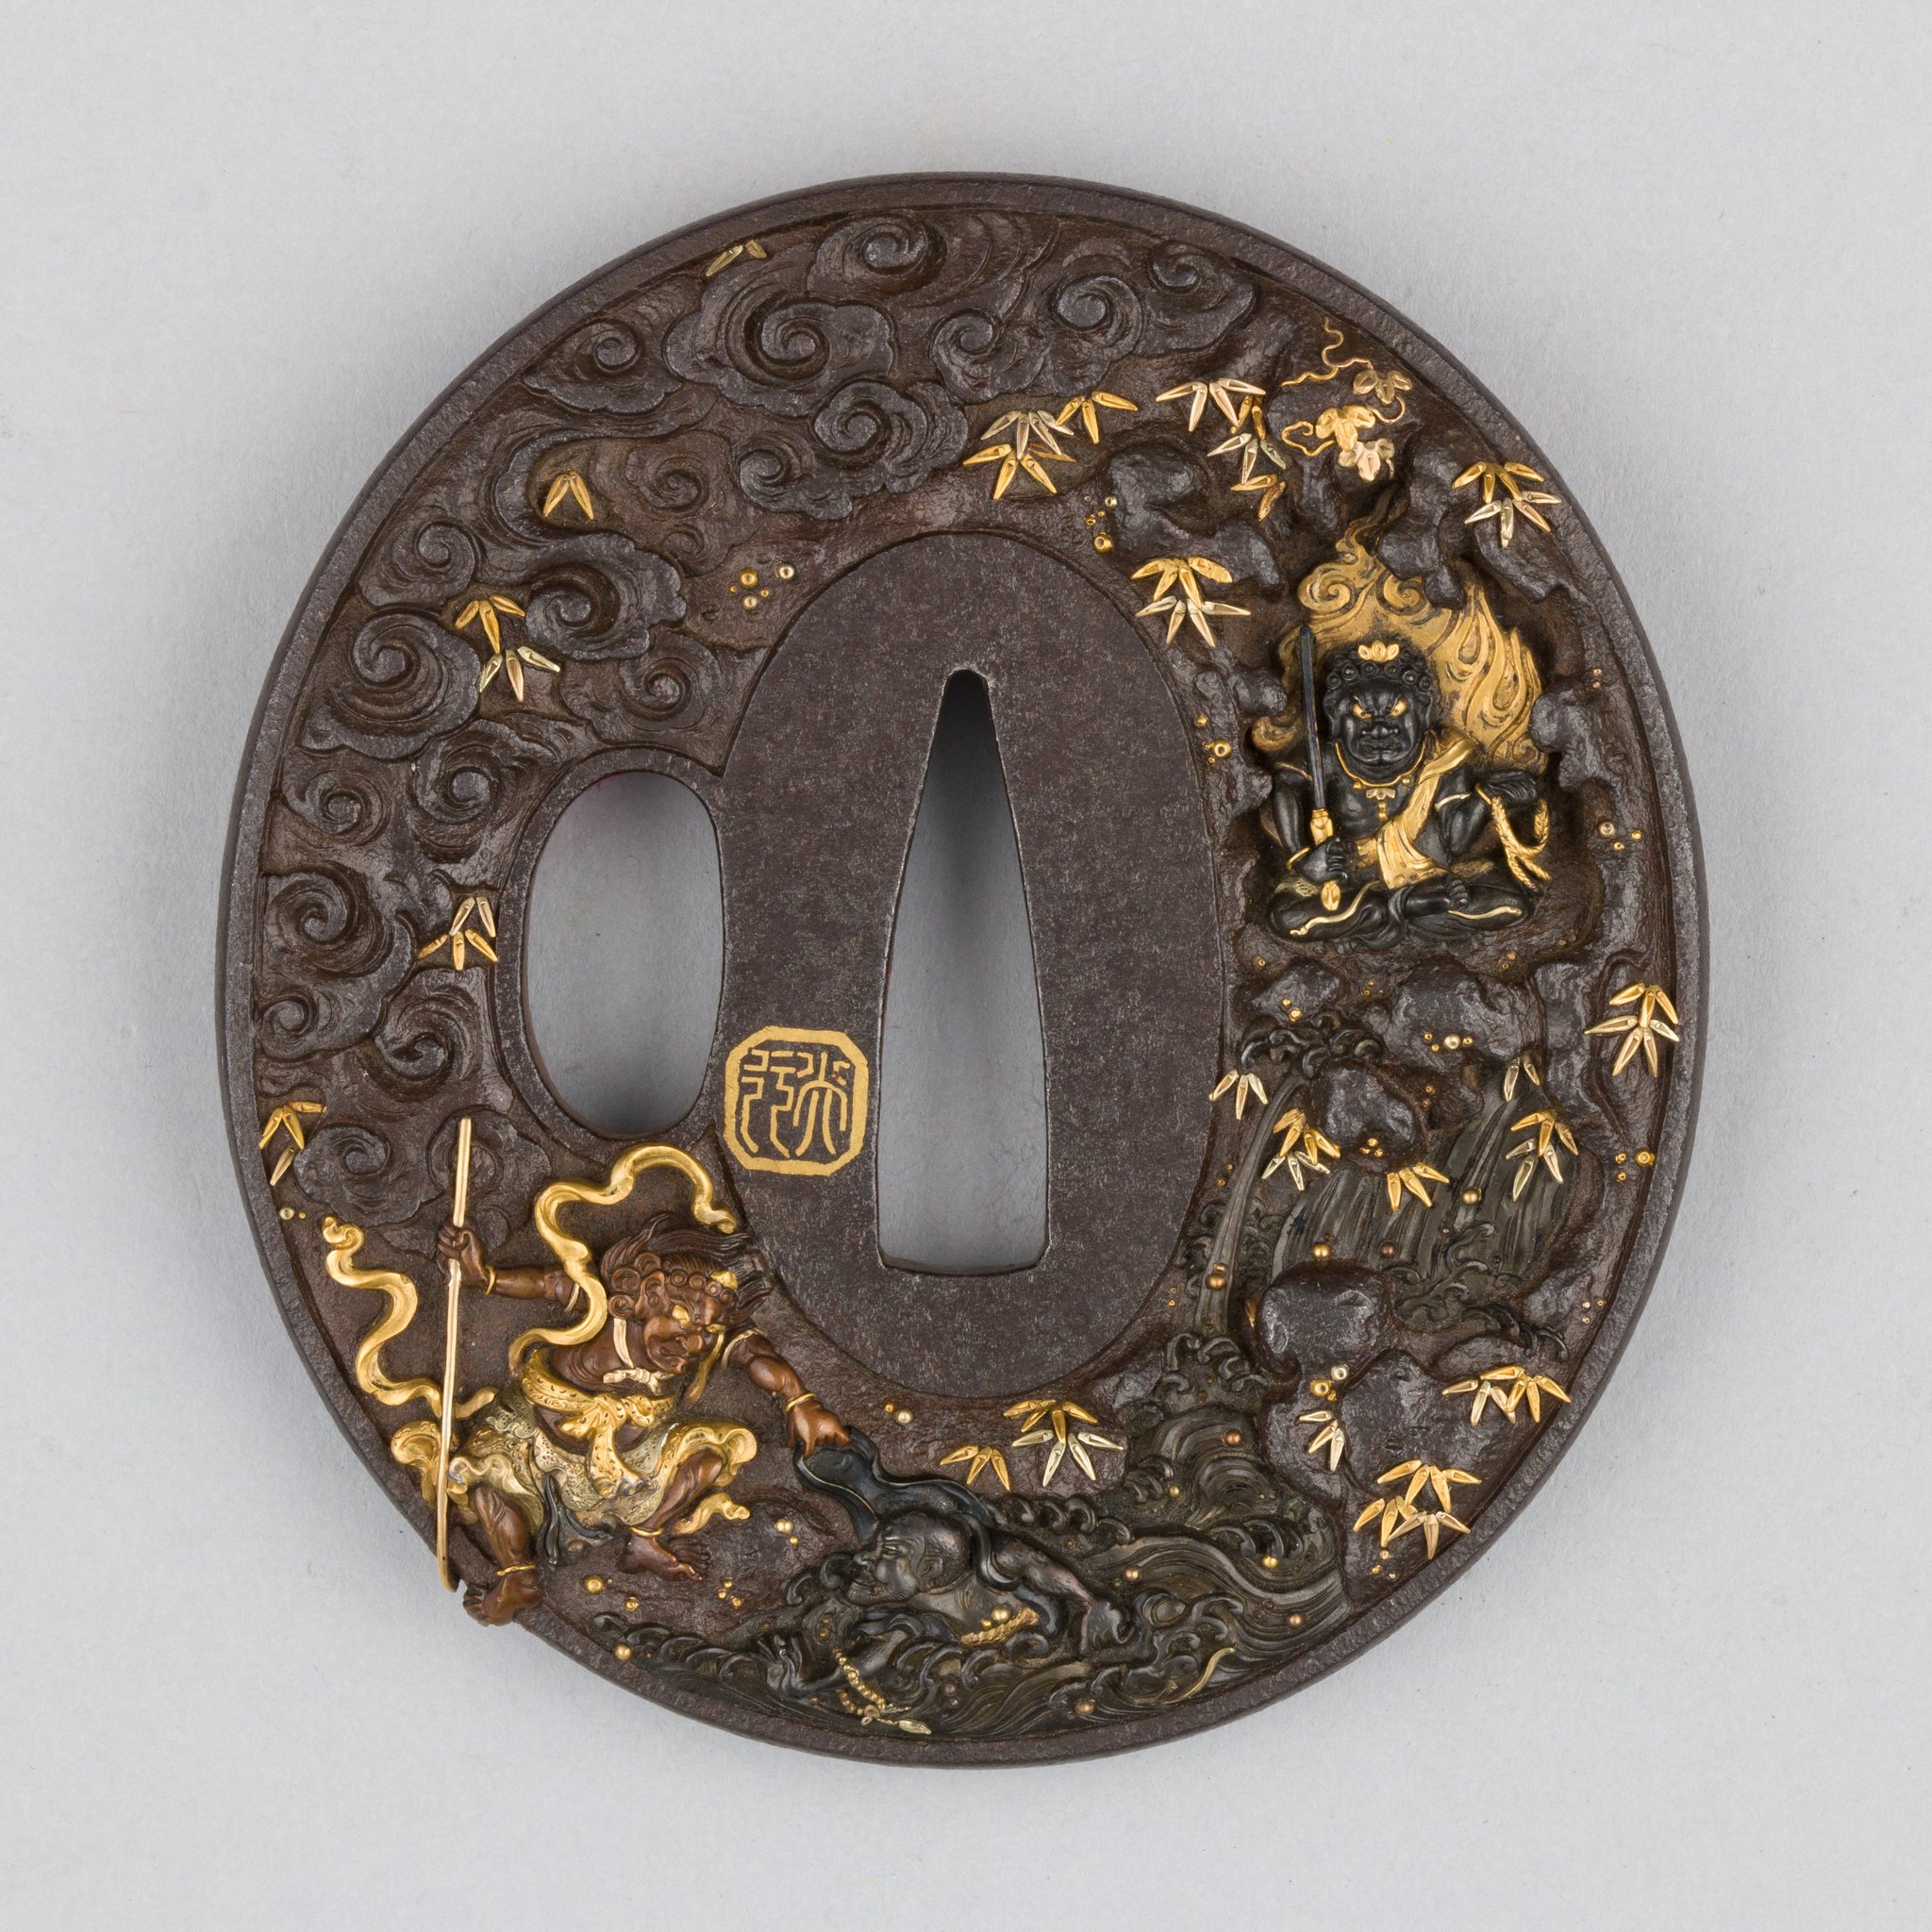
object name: sword guard tsuba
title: Sword Guard (Tsuba)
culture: japanese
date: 1701-1800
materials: copper, gold alloy, gold, iron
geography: japan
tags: men